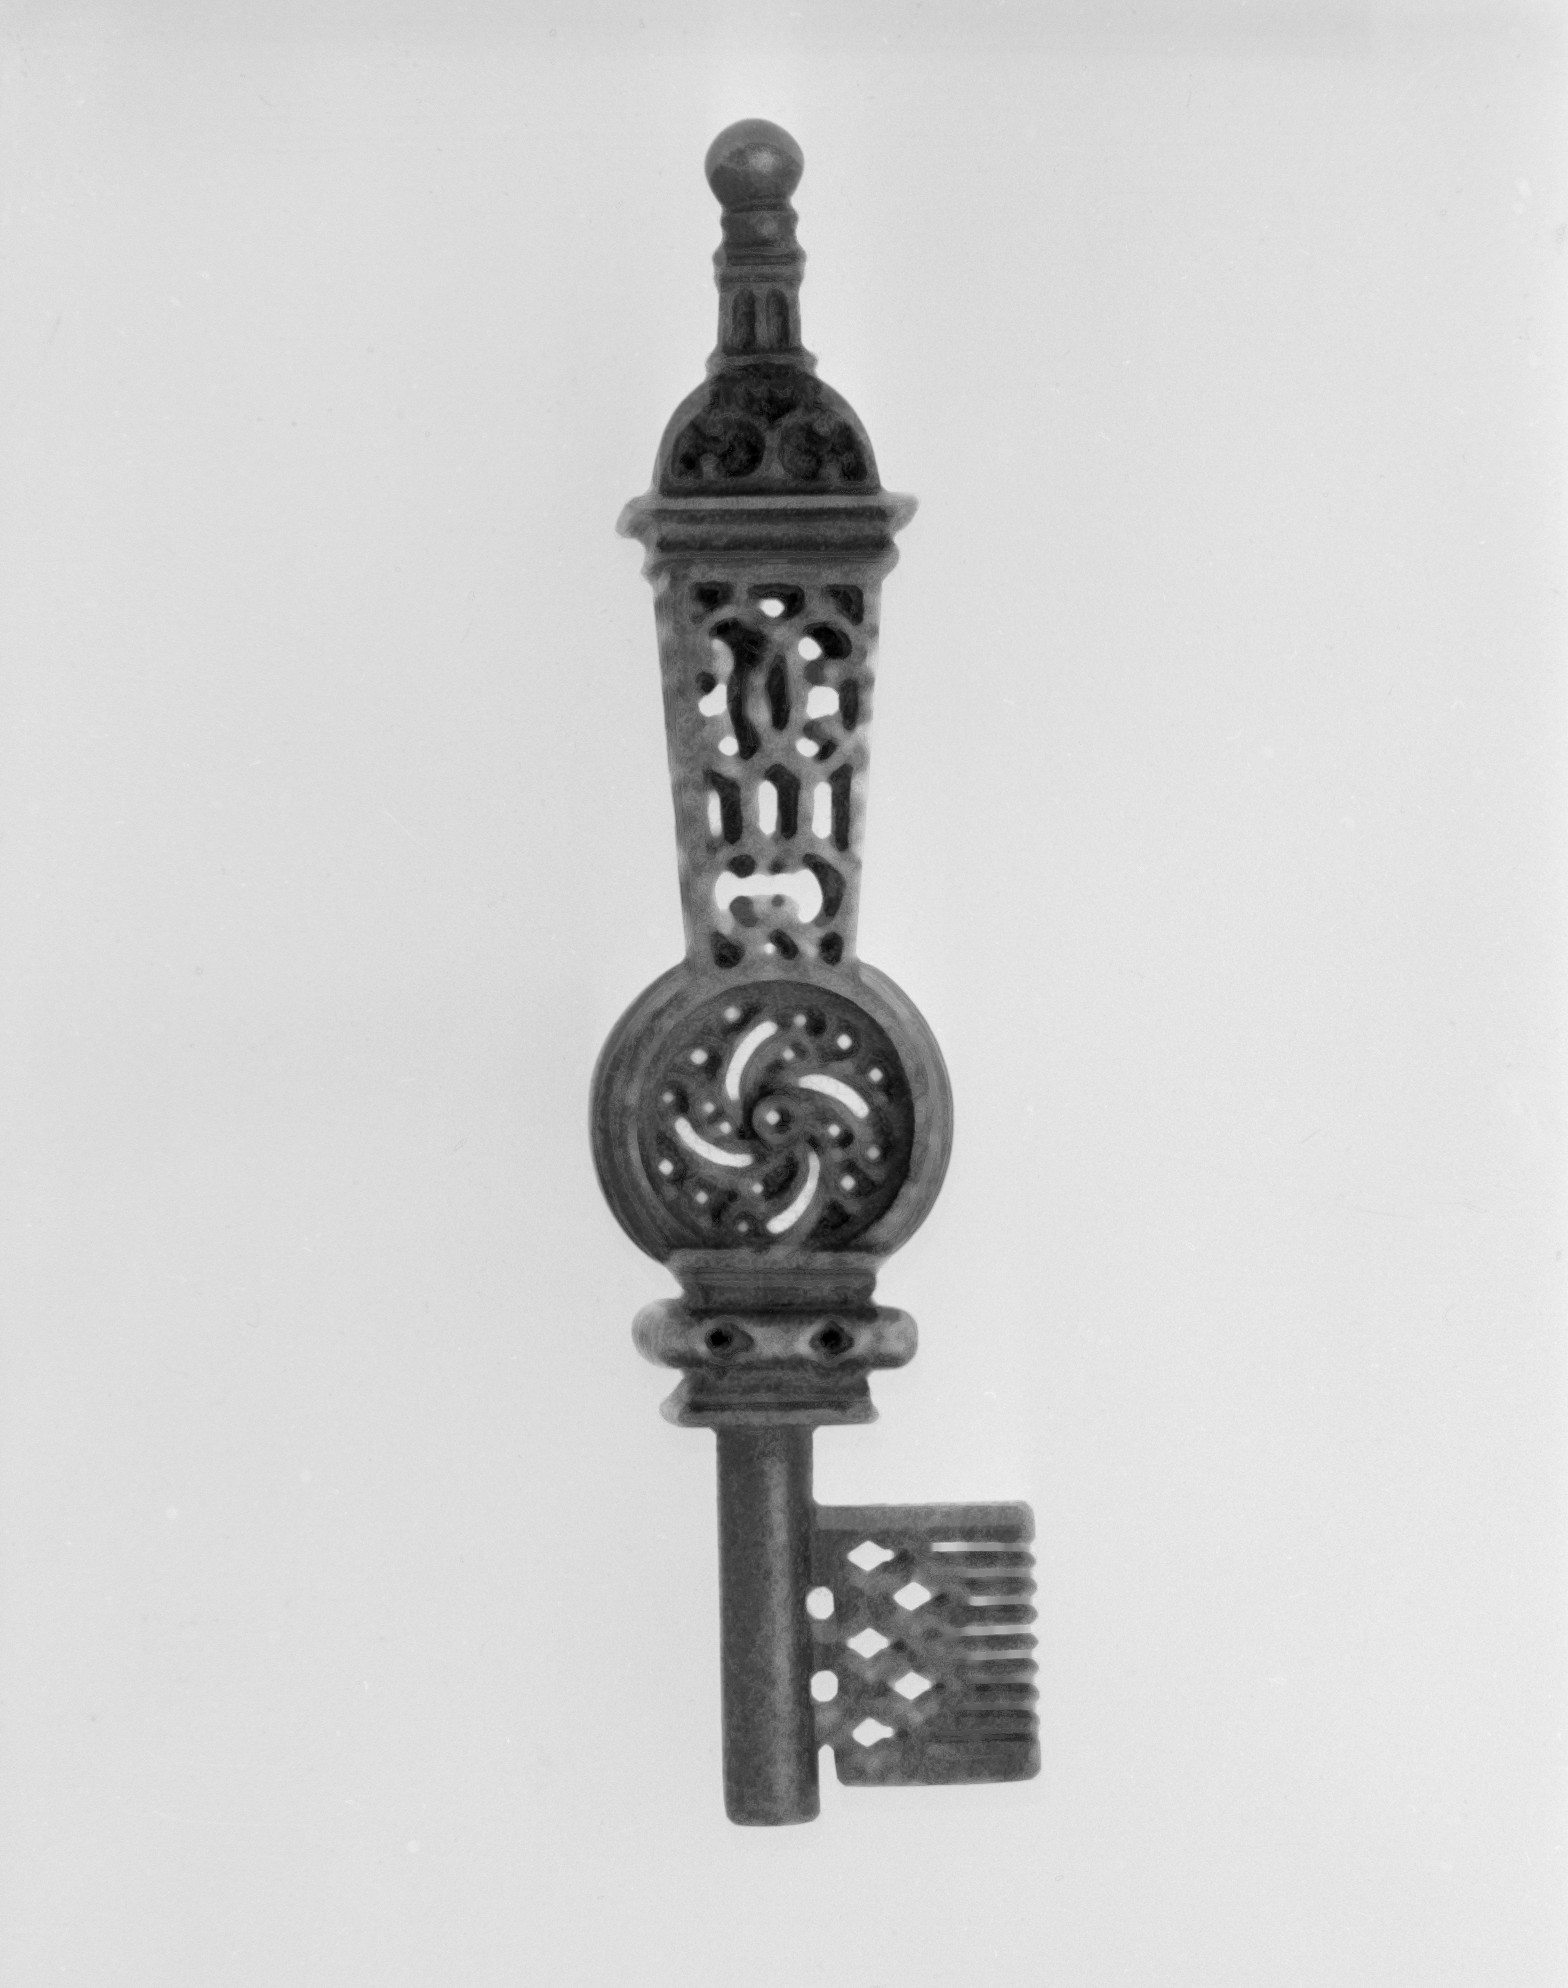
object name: key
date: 1501-1600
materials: steel